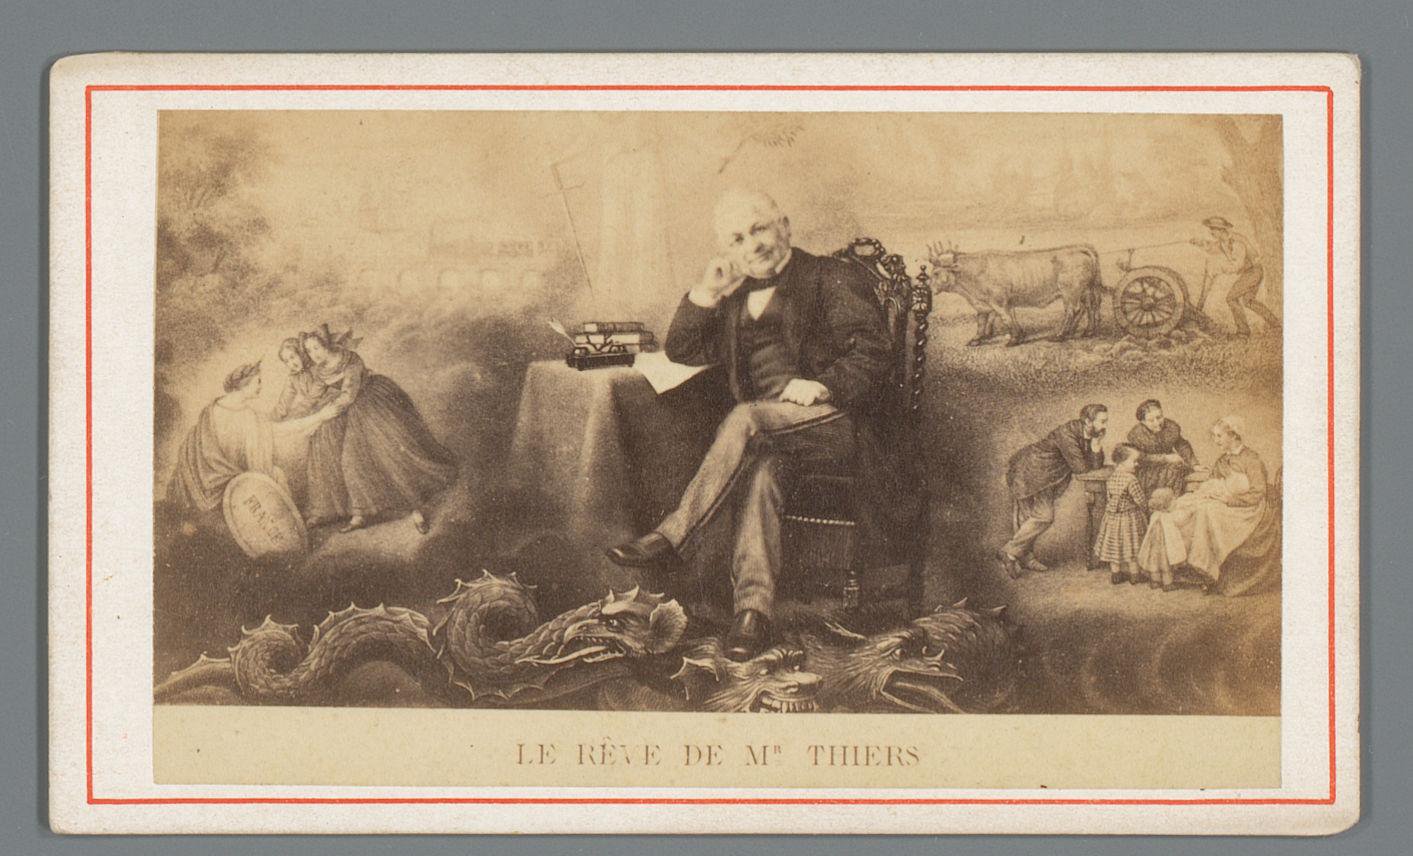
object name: photograph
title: Le Rêve de Mr Thiers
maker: Anonymous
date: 1870-1877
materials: cardboard, paper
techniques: albumen print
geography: france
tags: marseille, adult man, dream, france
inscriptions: inscription: ‘Le Rêve de Mr Thiers’, inscription: ‘Photomontage/ politique’